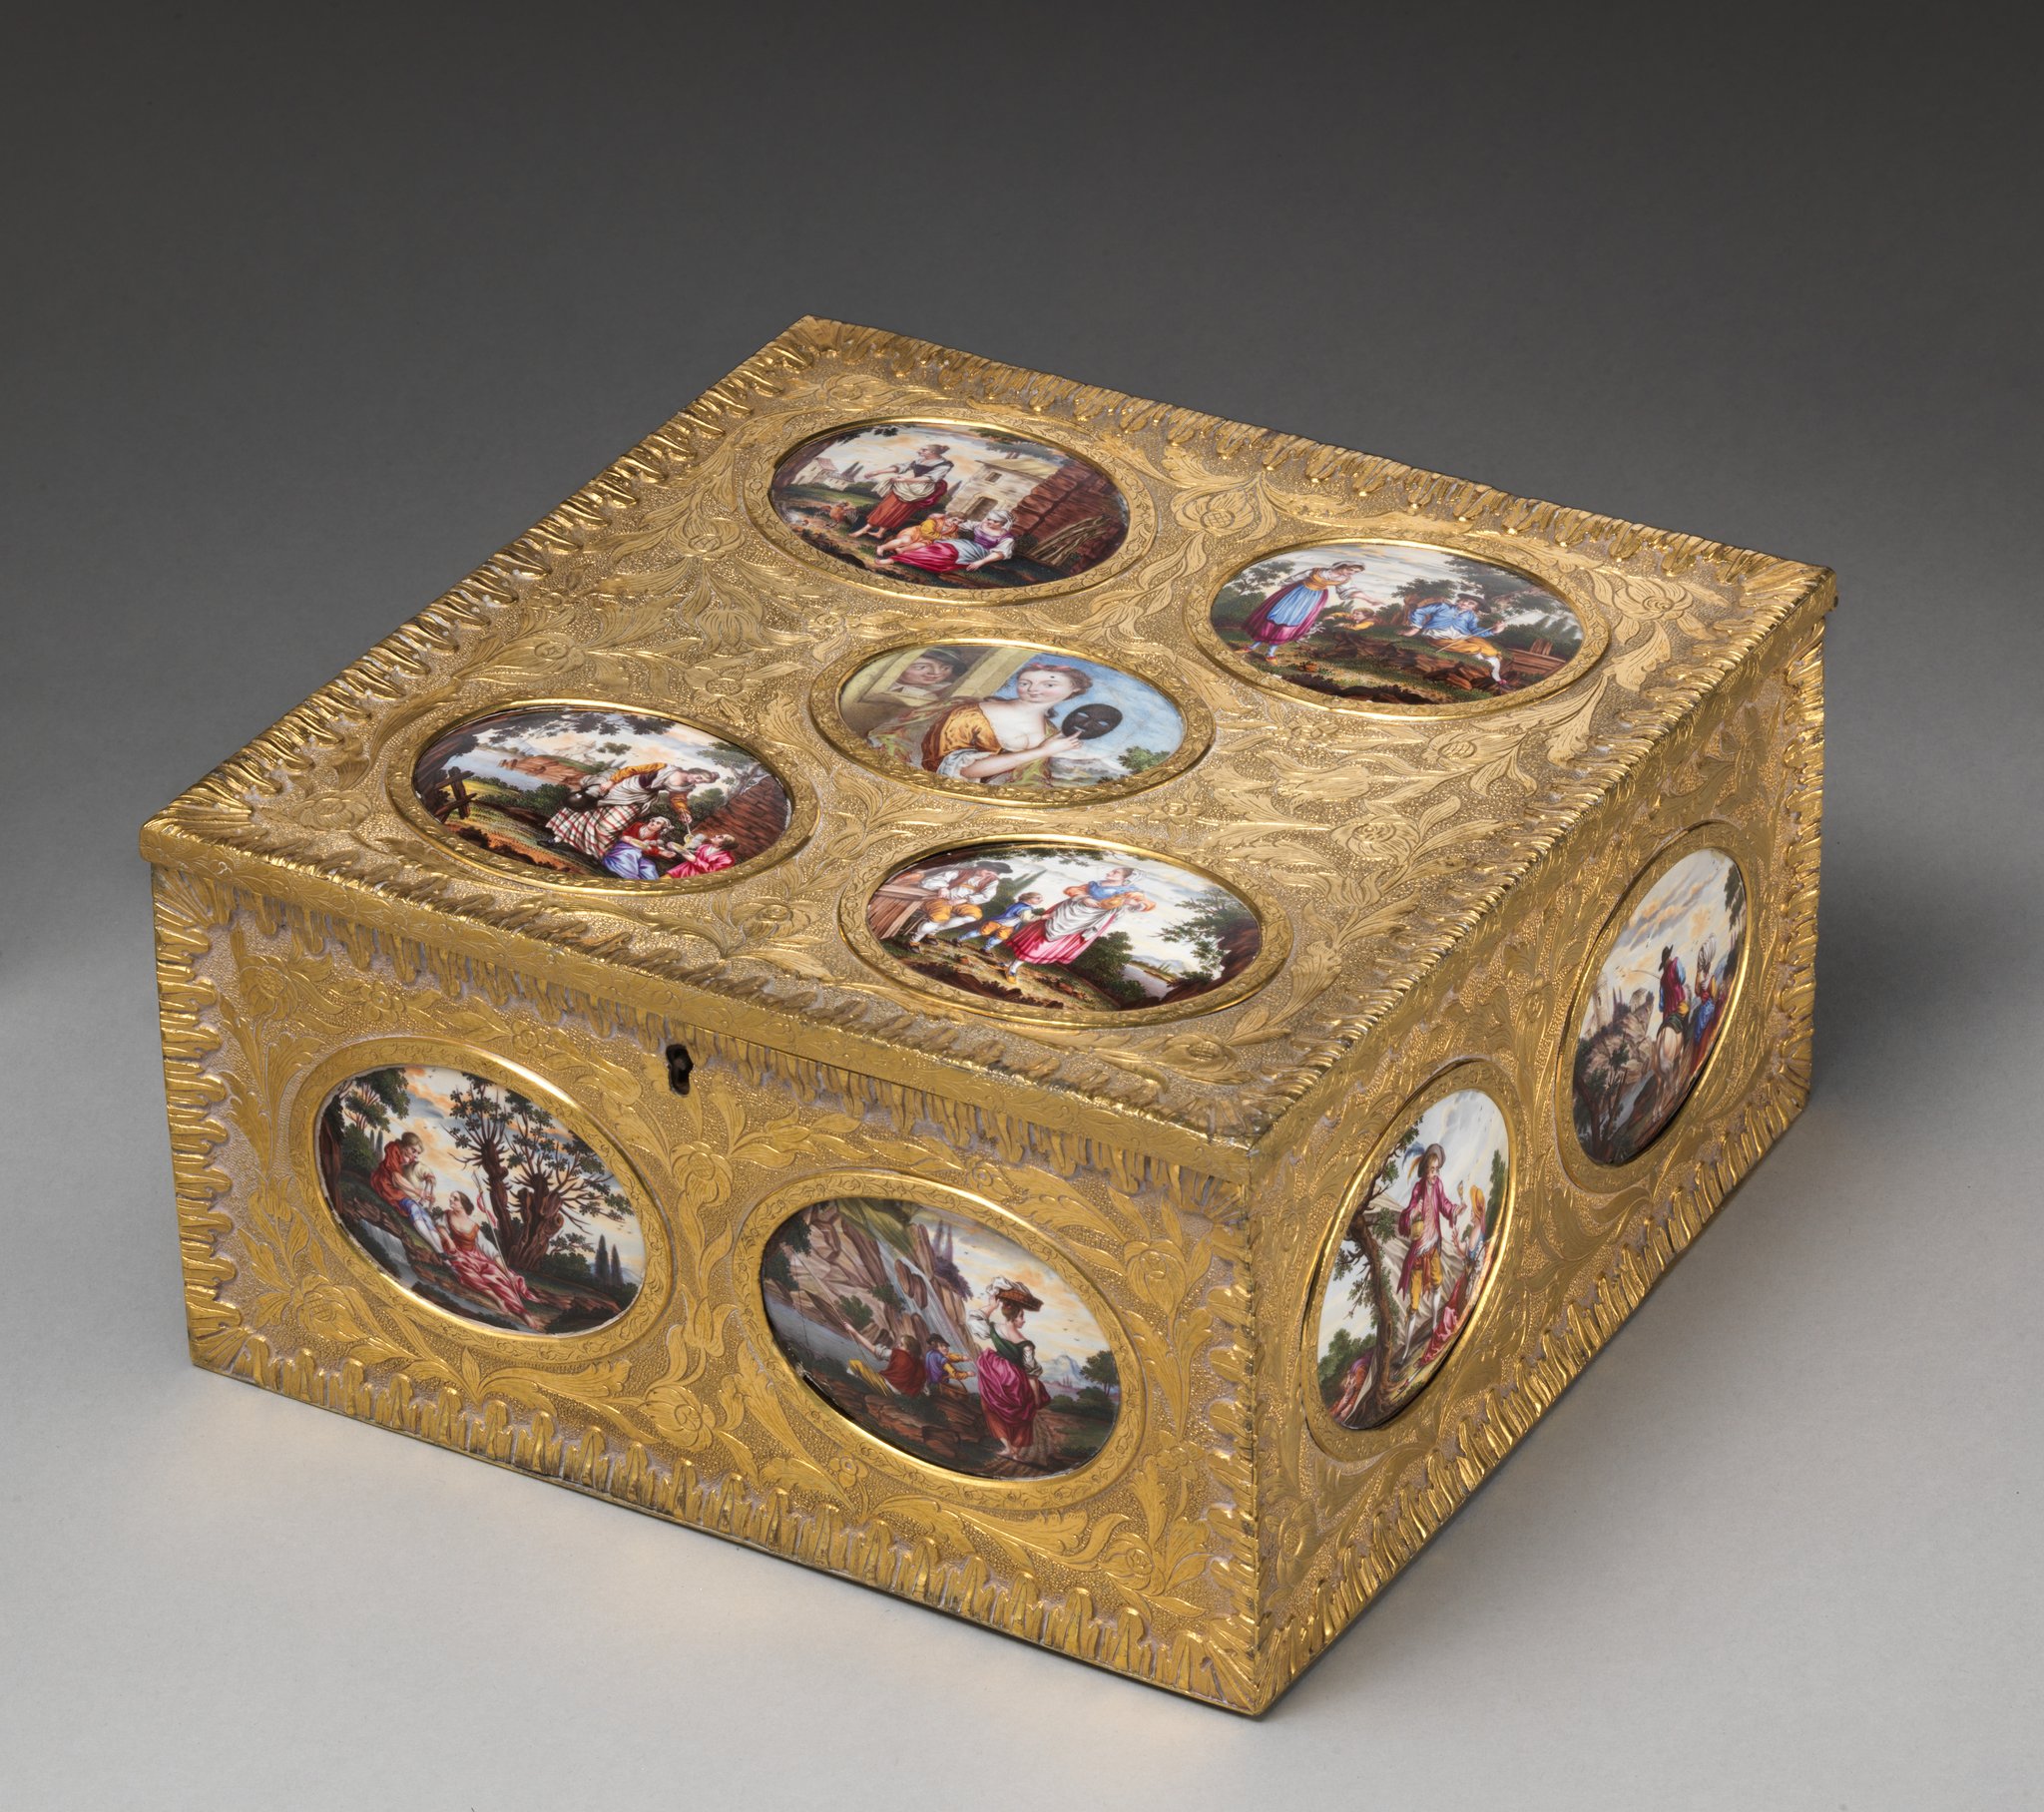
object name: casket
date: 1770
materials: copper, enamel, gilt, metal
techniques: painting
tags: children,men,women